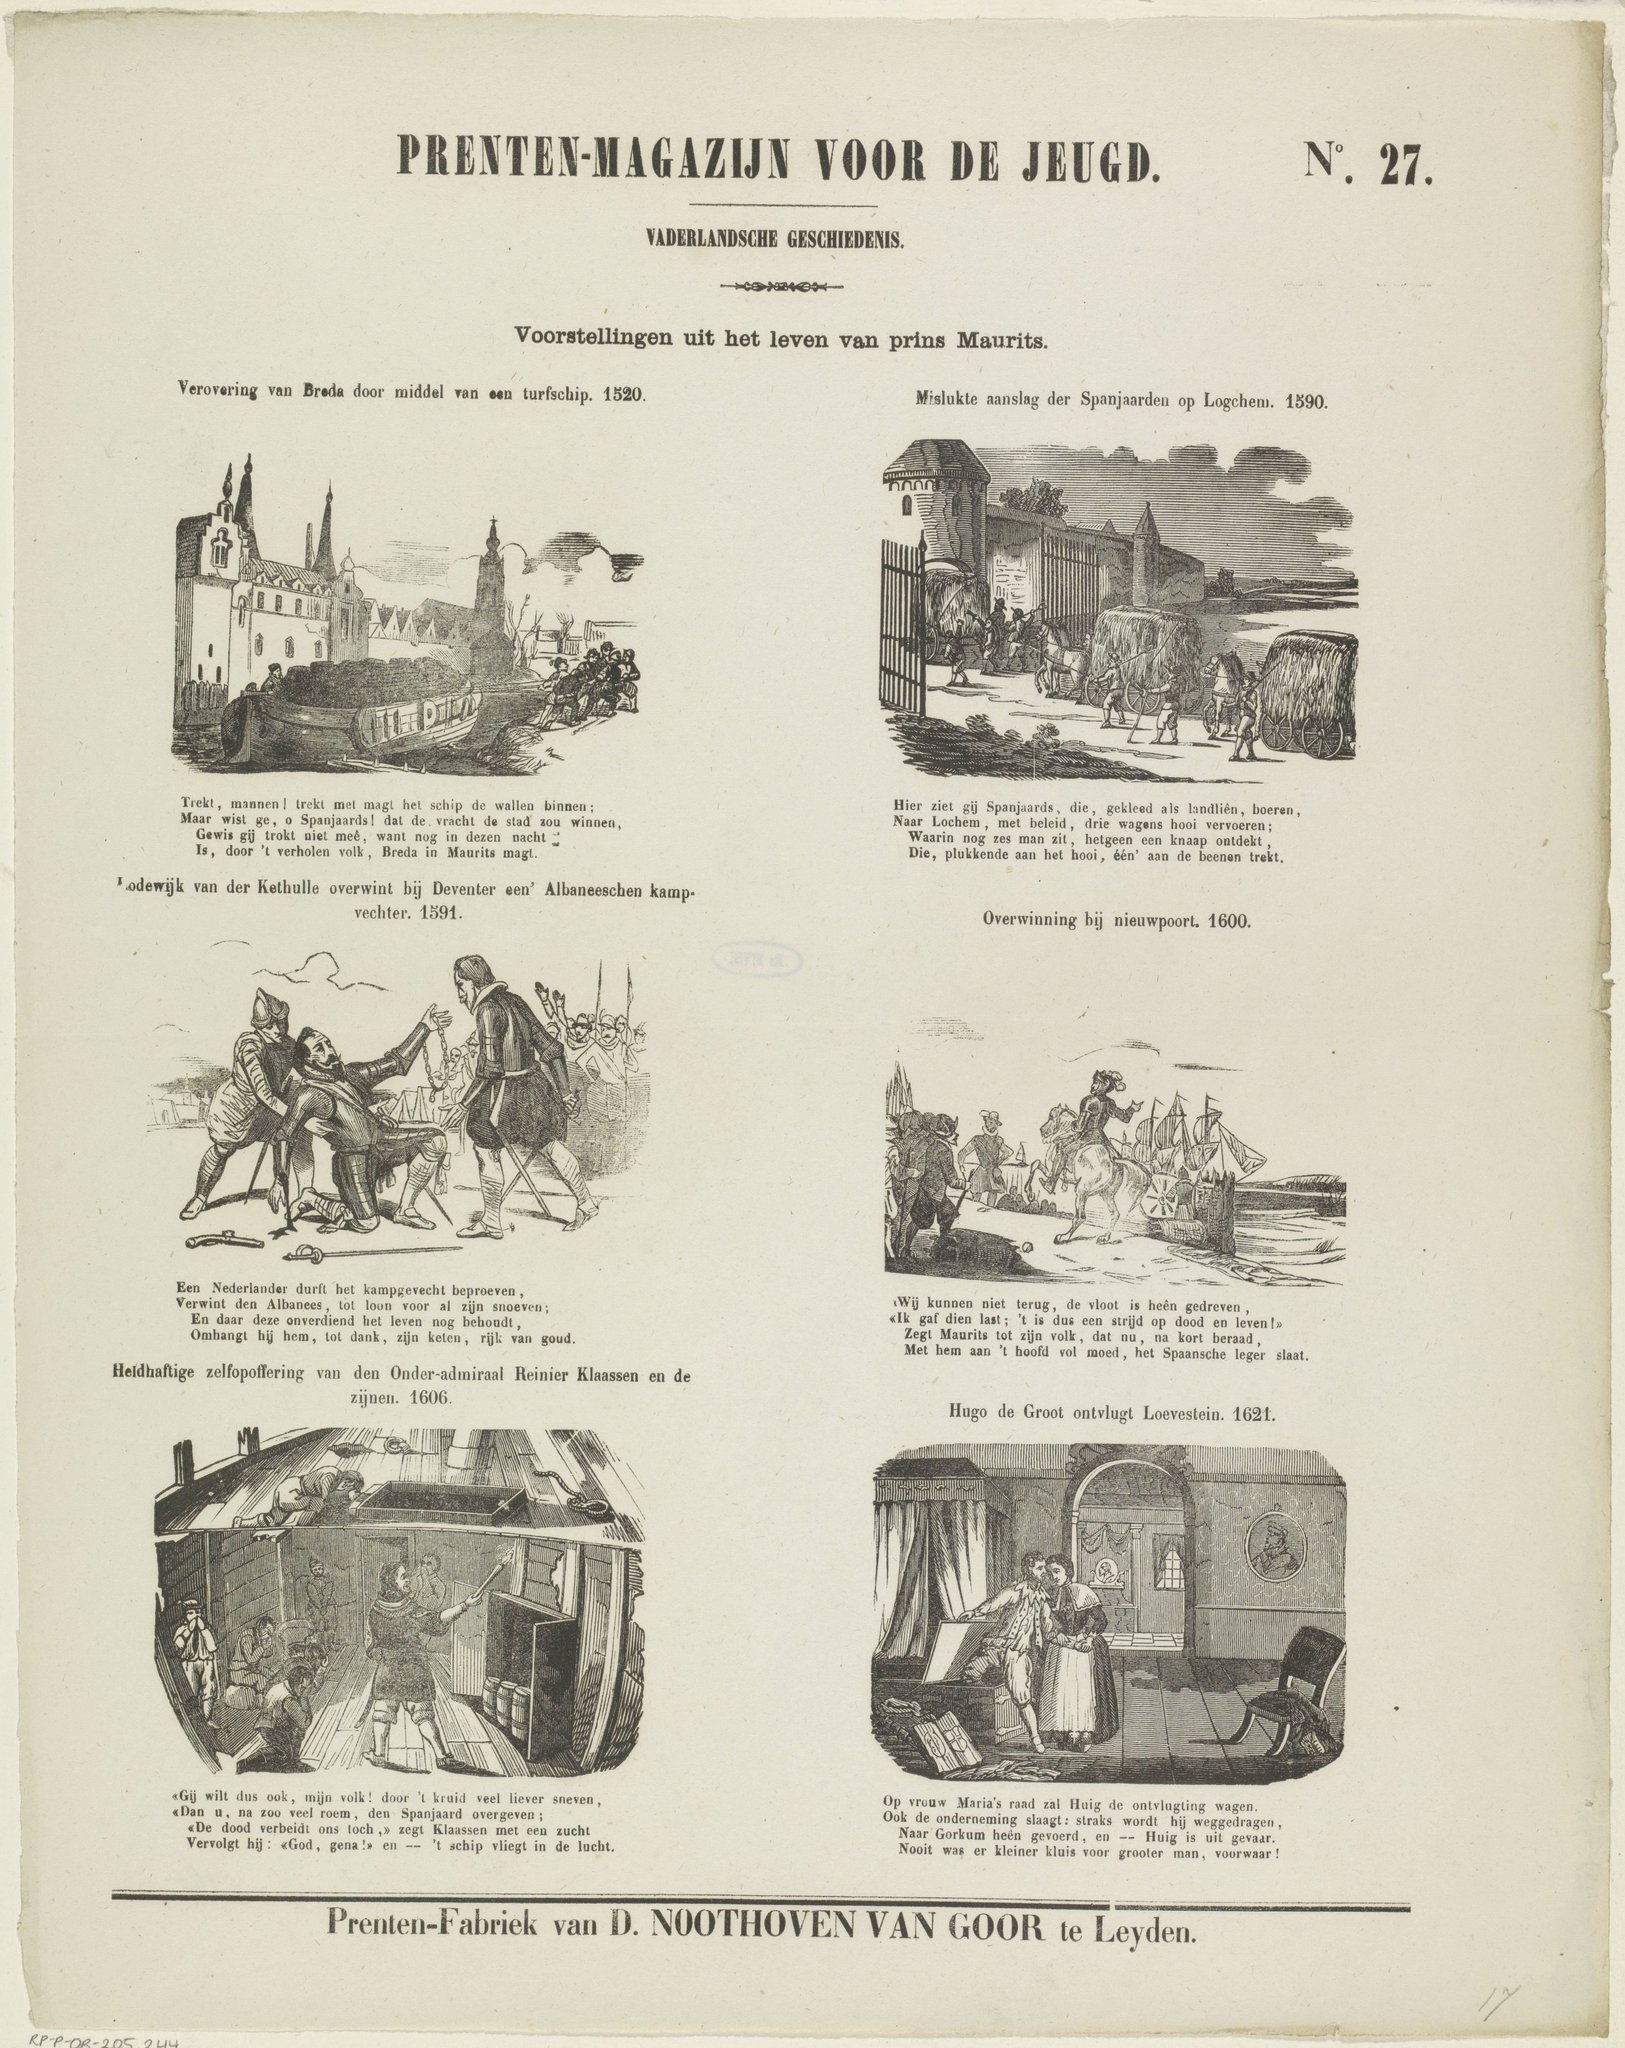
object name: popular print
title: Prenten-magazijn voor de jeugd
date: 1850-1881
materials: paper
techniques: letterpress printing, engraving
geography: leiden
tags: delft, hugo de groot, history, loevestein castle, deventer, battle of nieuwpoort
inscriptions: collector's mark: Lugt 2228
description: Blad met 6 voorstellingen van gebeurtenissen uit de vaderlandse geschiedenis. Boven elke voorstelling een titel en onder elke voorstelling een vierregelig vers. Genummerd rechtsboven: No. 27.